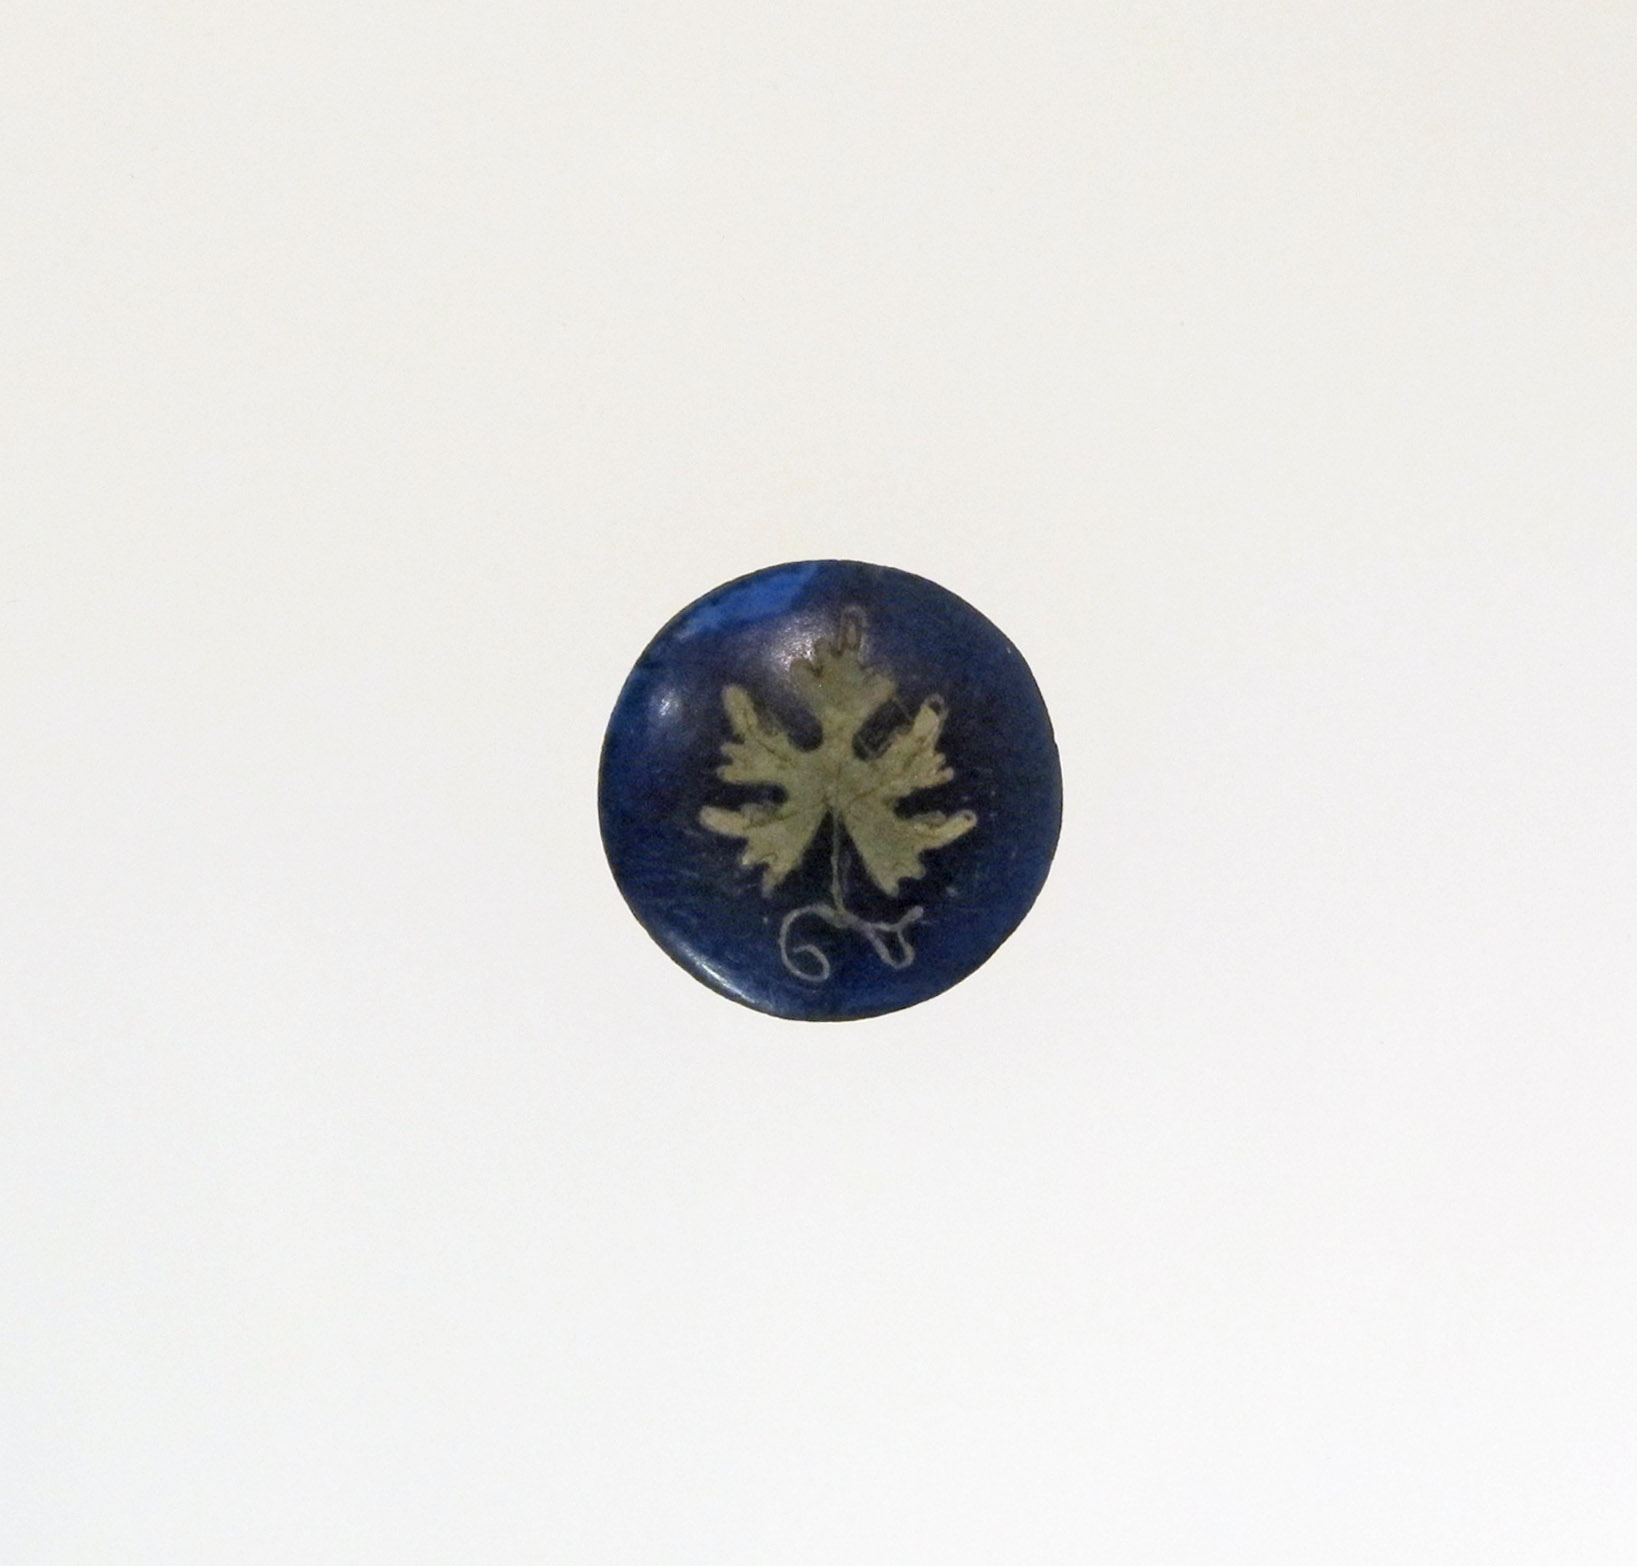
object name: mosaic block inlay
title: Glass and gold inlay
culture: roman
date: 34 BCE-100 CE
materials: glass